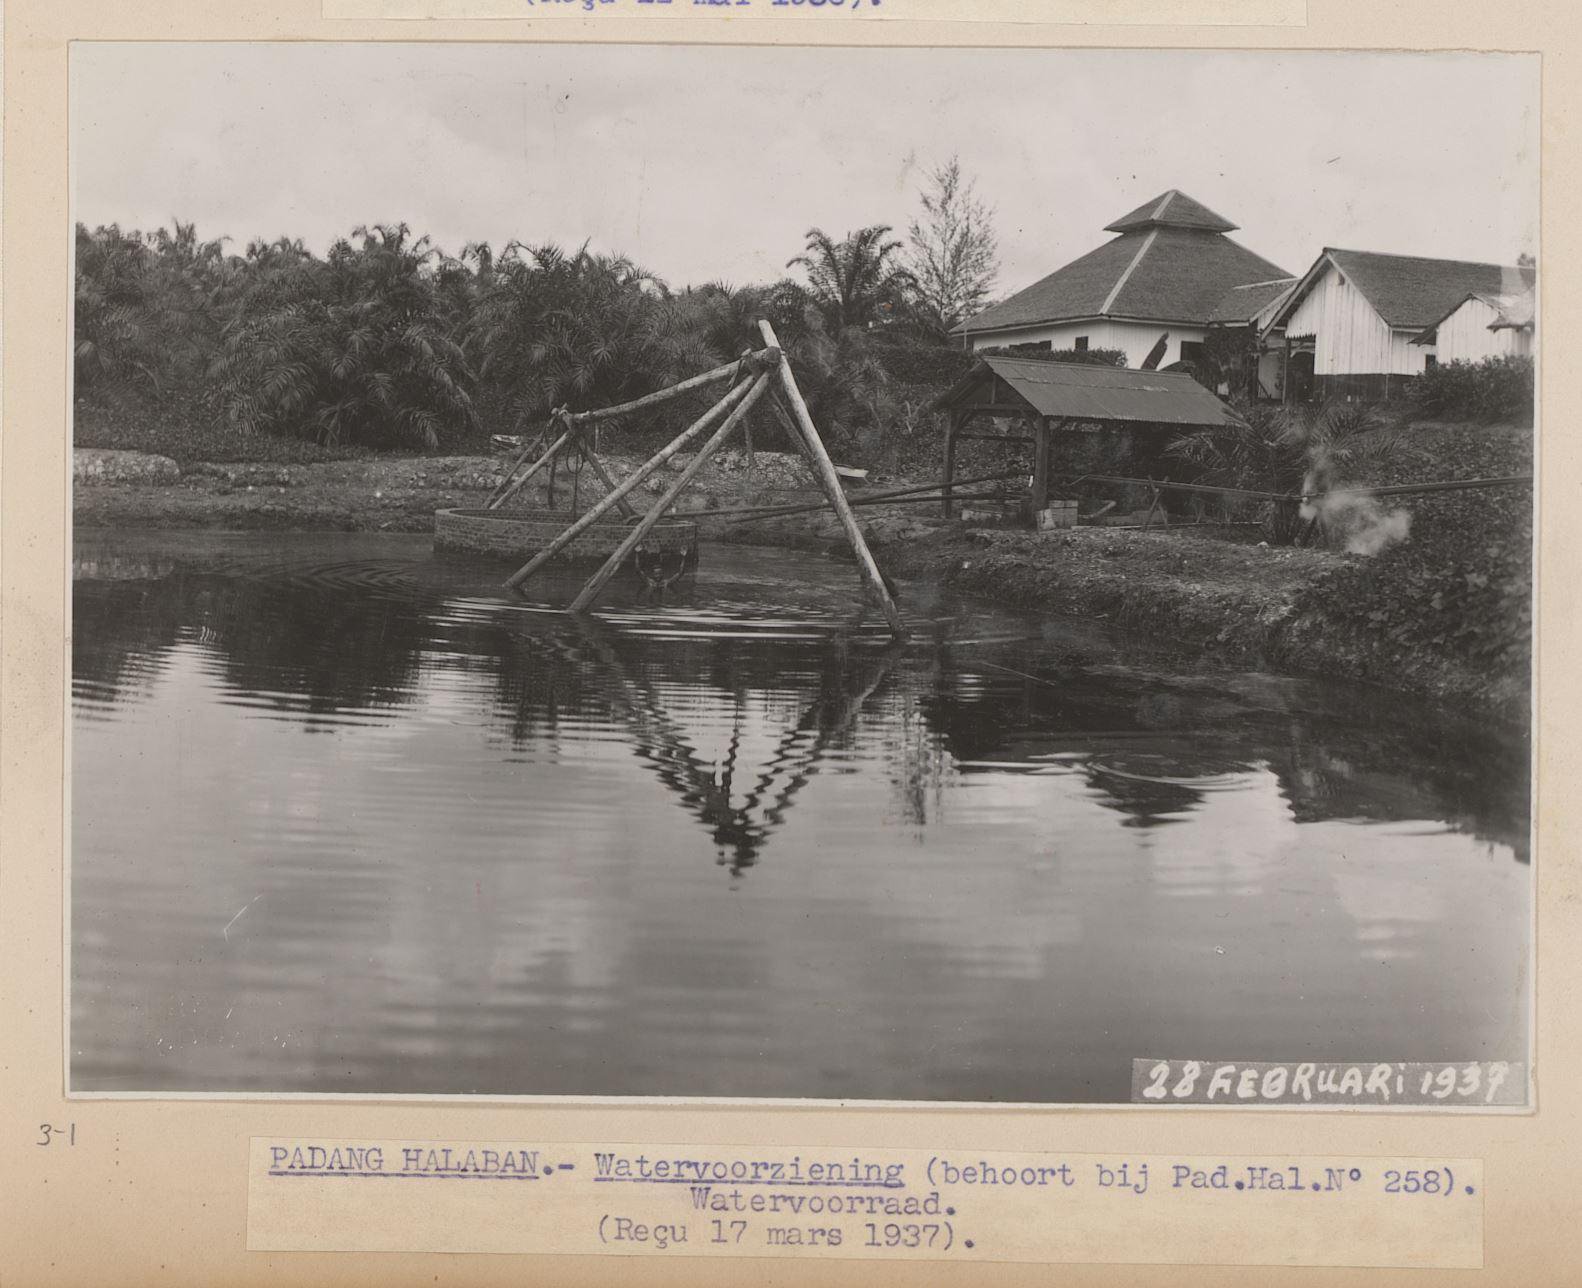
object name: photograph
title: Padang Halaban - Watervoorziening (behoort bij Pad. Hal. No. 258). Watervoorraad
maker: shibaya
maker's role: fotograaf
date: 1937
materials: photographic support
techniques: gelatin silver print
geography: sumatra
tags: plantation, water-supply and draining, pipework (in house or building)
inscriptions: inscription: ‘28 februari 1937’, inscription: ‘Padang Halaban - Watervoorziening (behoort bij Pad. Hal. No. 258). Watervoorraad (Reçu 17 mars 1937)’, name: ‘Shibaya R. Prapat’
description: Watervoorraad en installatie voor de watervoorziening op de plantage Padang Halaban, 1937. Onderdeel van het fotoalbum over de plantages Pernantian en Brussel van de Sumatra Caoutchouc Maatschappij op de Oostkust van Sumatra in de jaren 1935-1939.